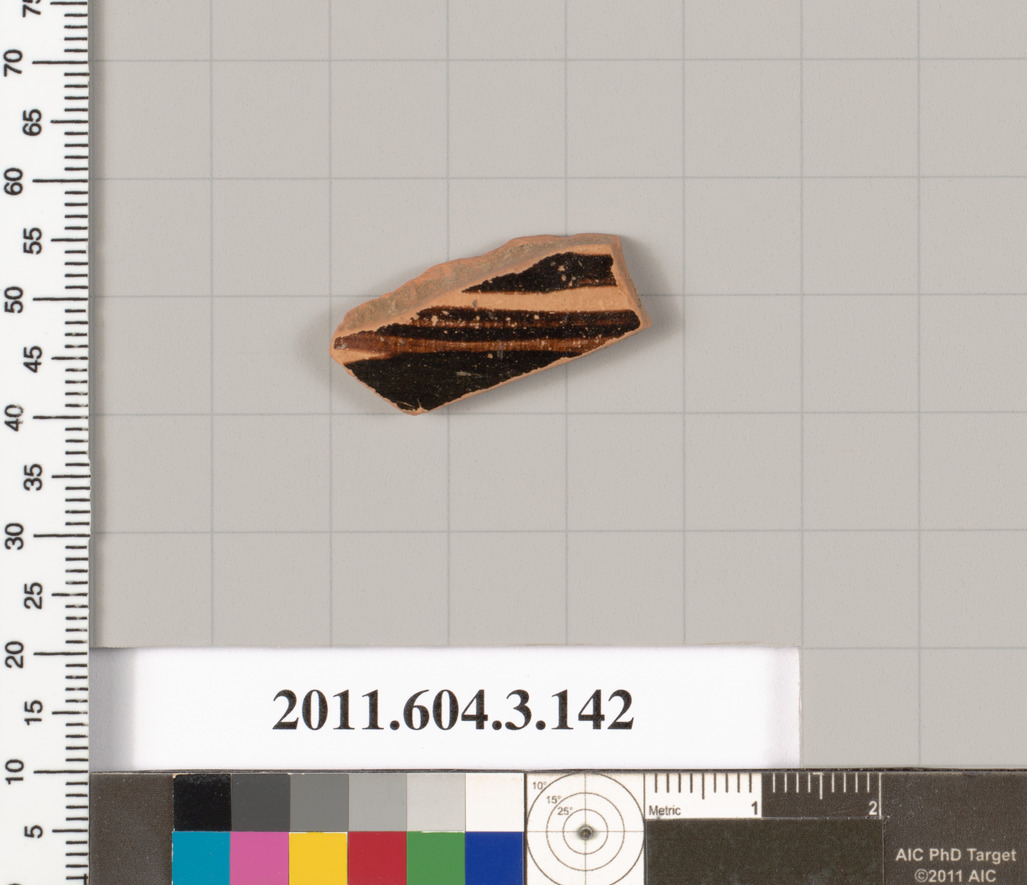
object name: undetermined closed shape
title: Terracotta fragment from a closed shape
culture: greek, attic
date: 600-401 BCE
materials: terracotta